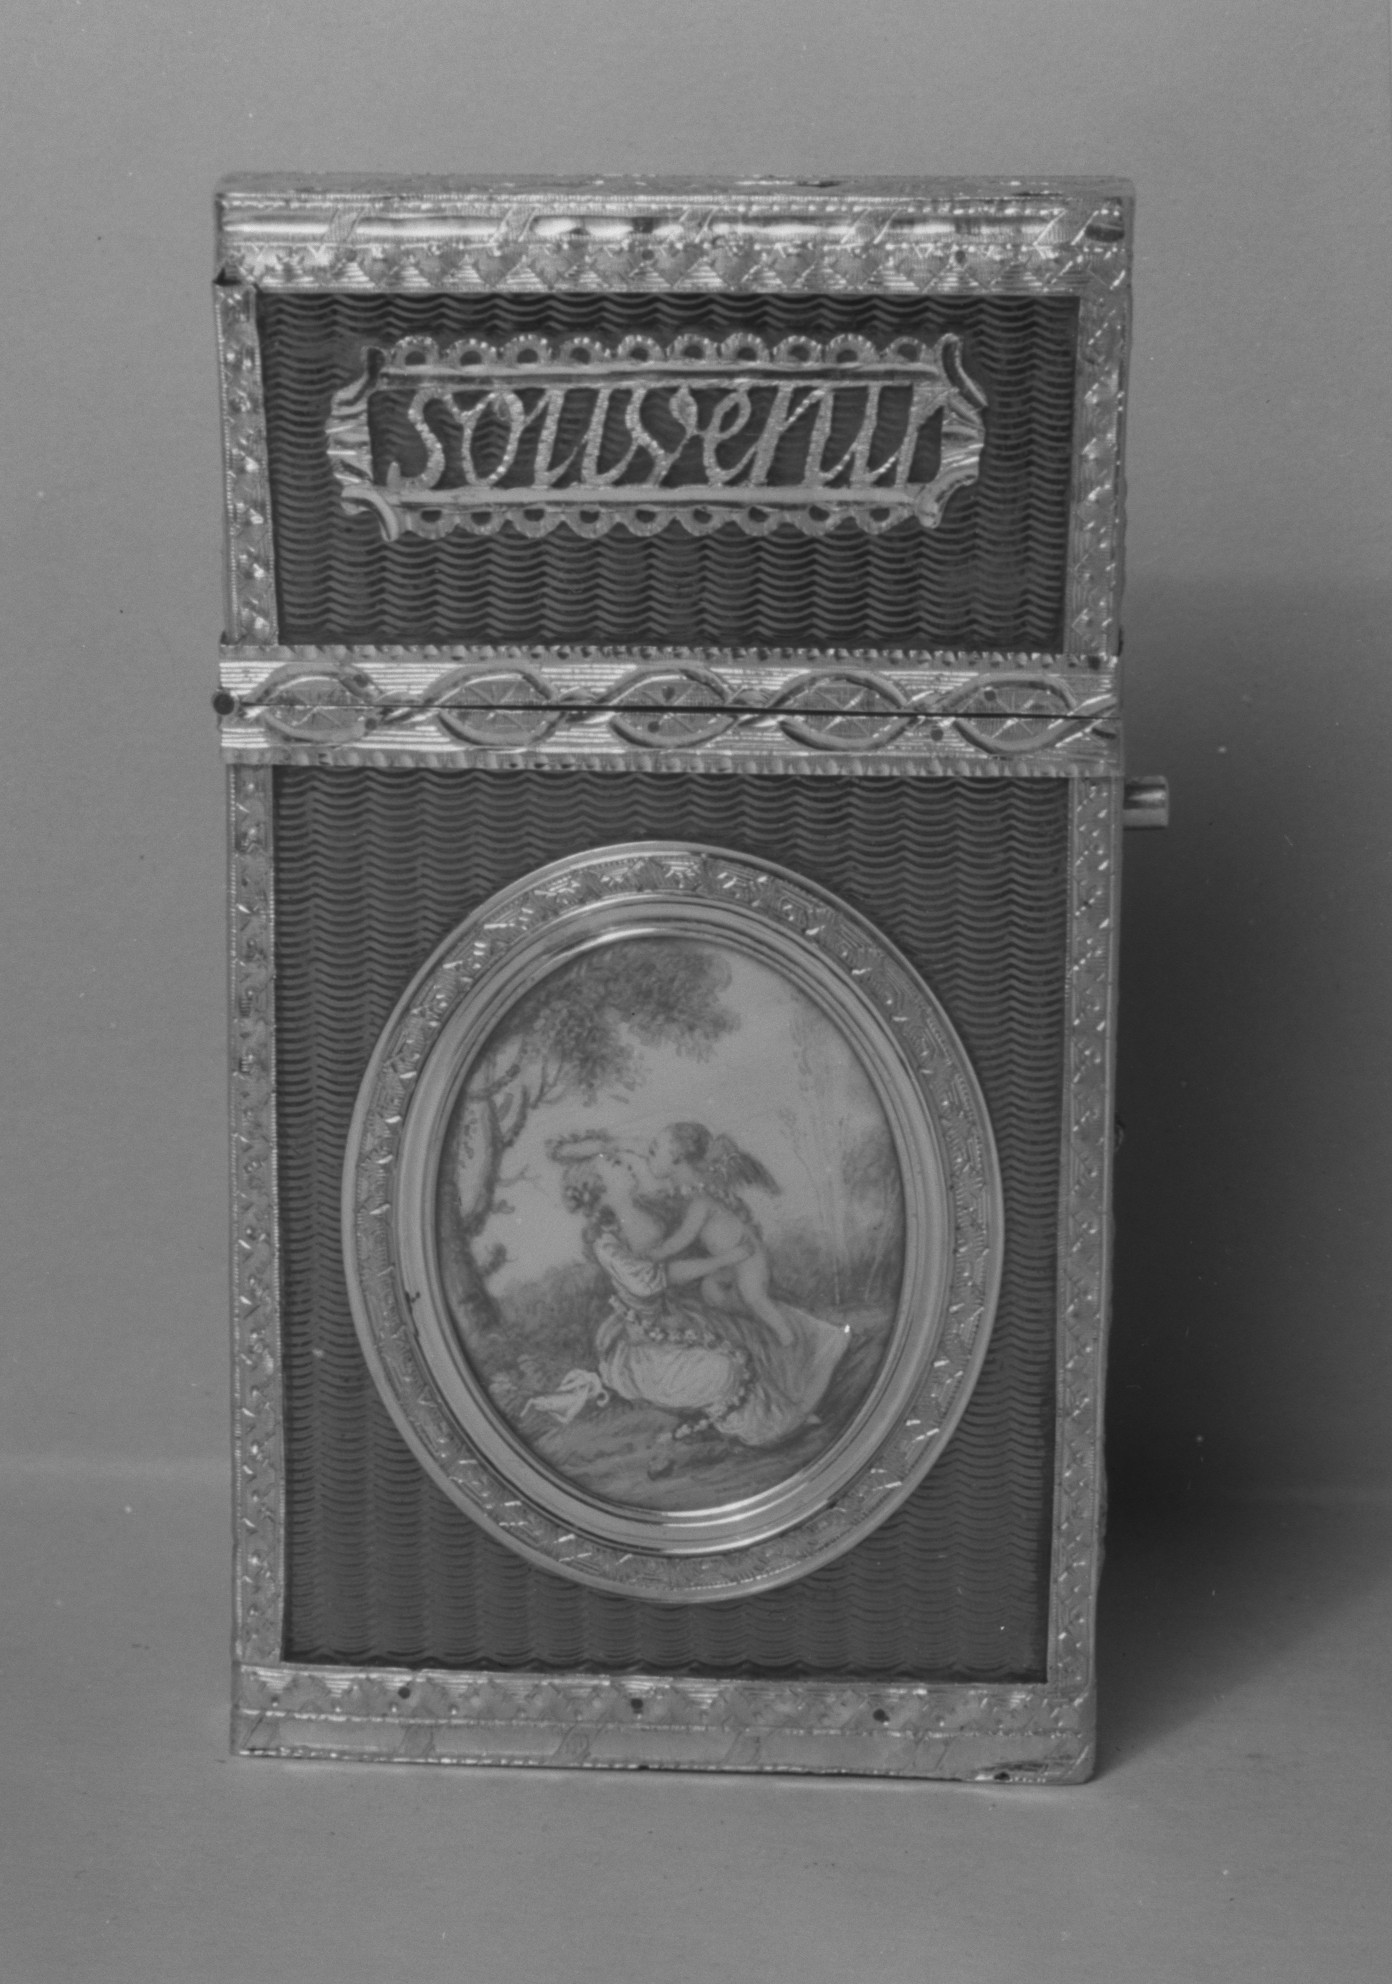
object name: souvenir, painting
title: Souvenir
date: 1773-1775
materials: foil, glass, gold, ivory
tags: women,cupid